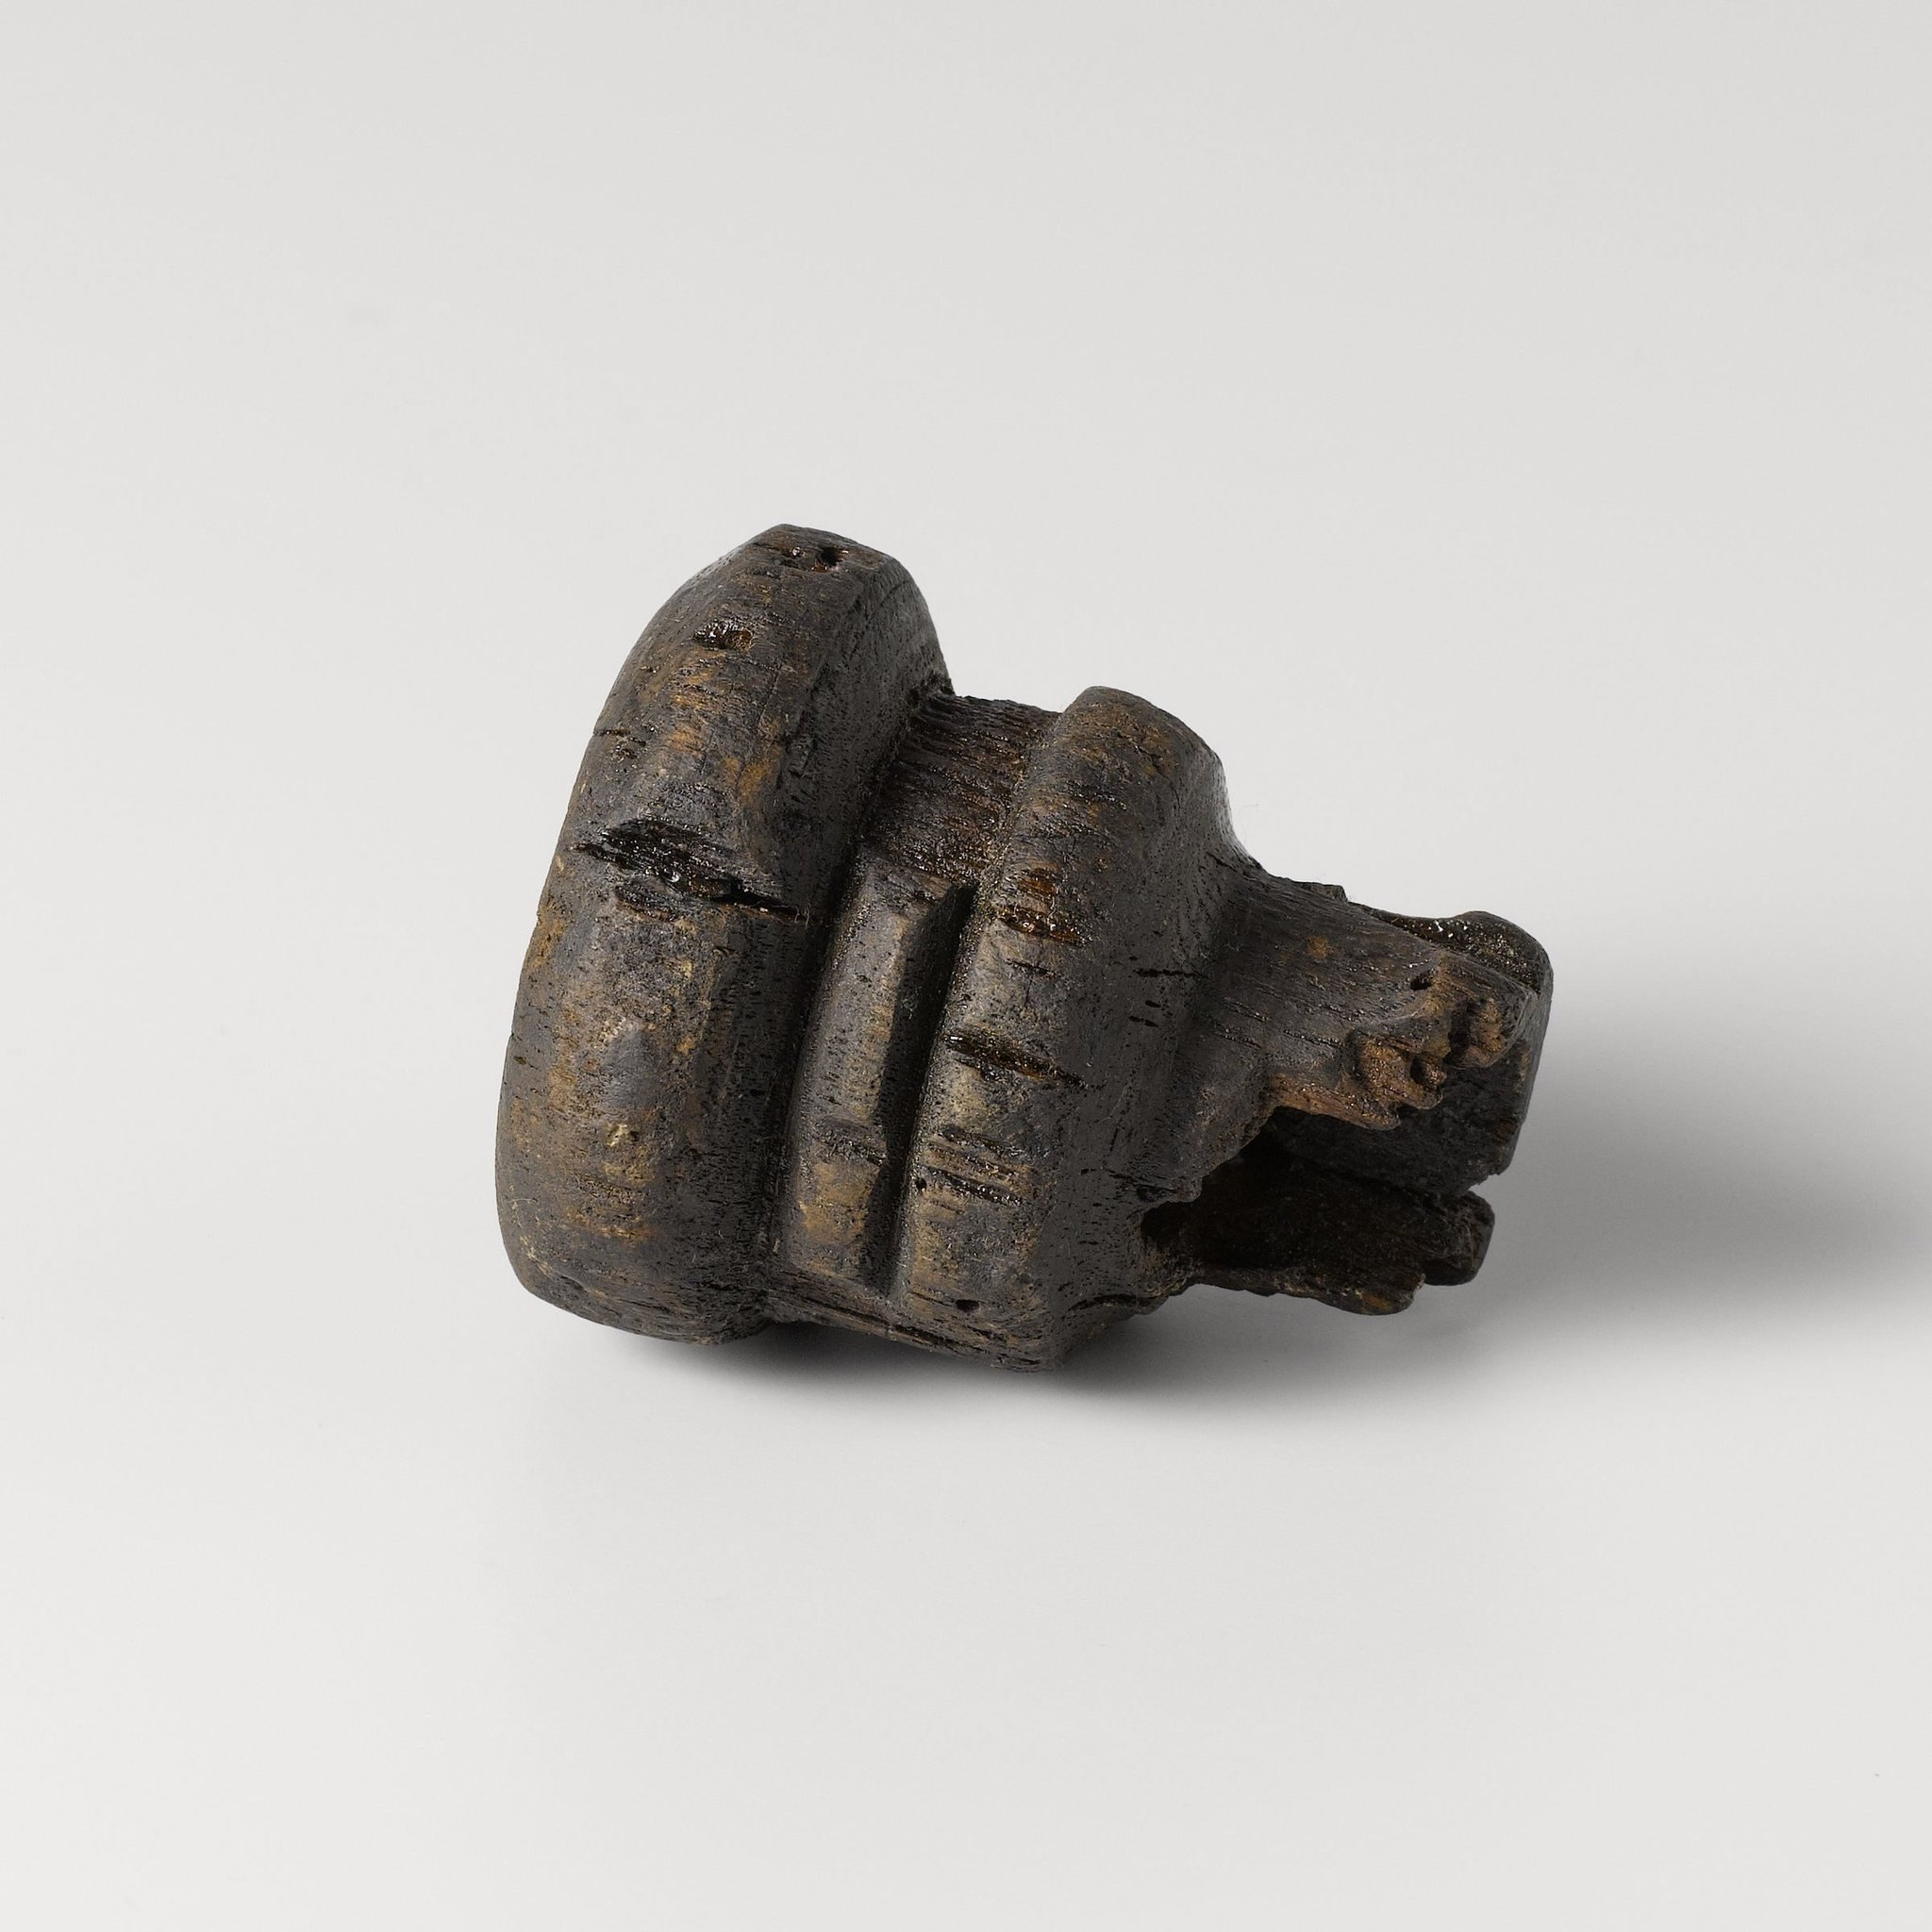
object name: knob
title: Druif of ronde knop van een zwengelboor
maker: Anonymous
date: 1590-1596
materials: wood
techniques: cutting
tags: willem barendsz., amsterdam, jacob van heemskerck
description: Druif of ronde knop van een zwengelboor. De druif hoort mogelijk bij NG-NM-7775.